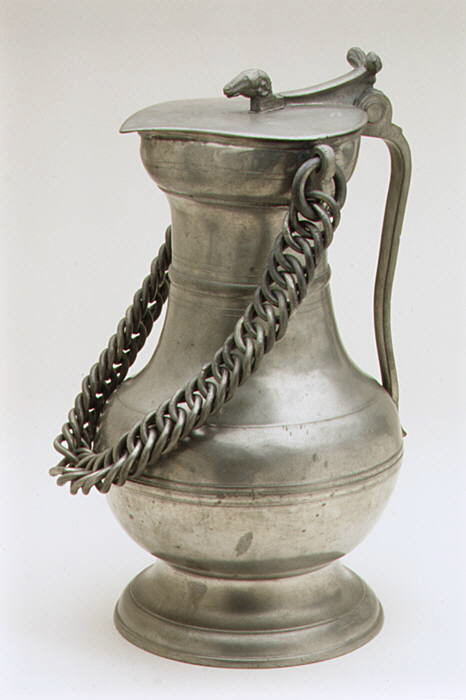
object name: flagon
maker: pier antoin simaval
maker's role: maker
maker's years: 1750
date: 1750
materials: pewter